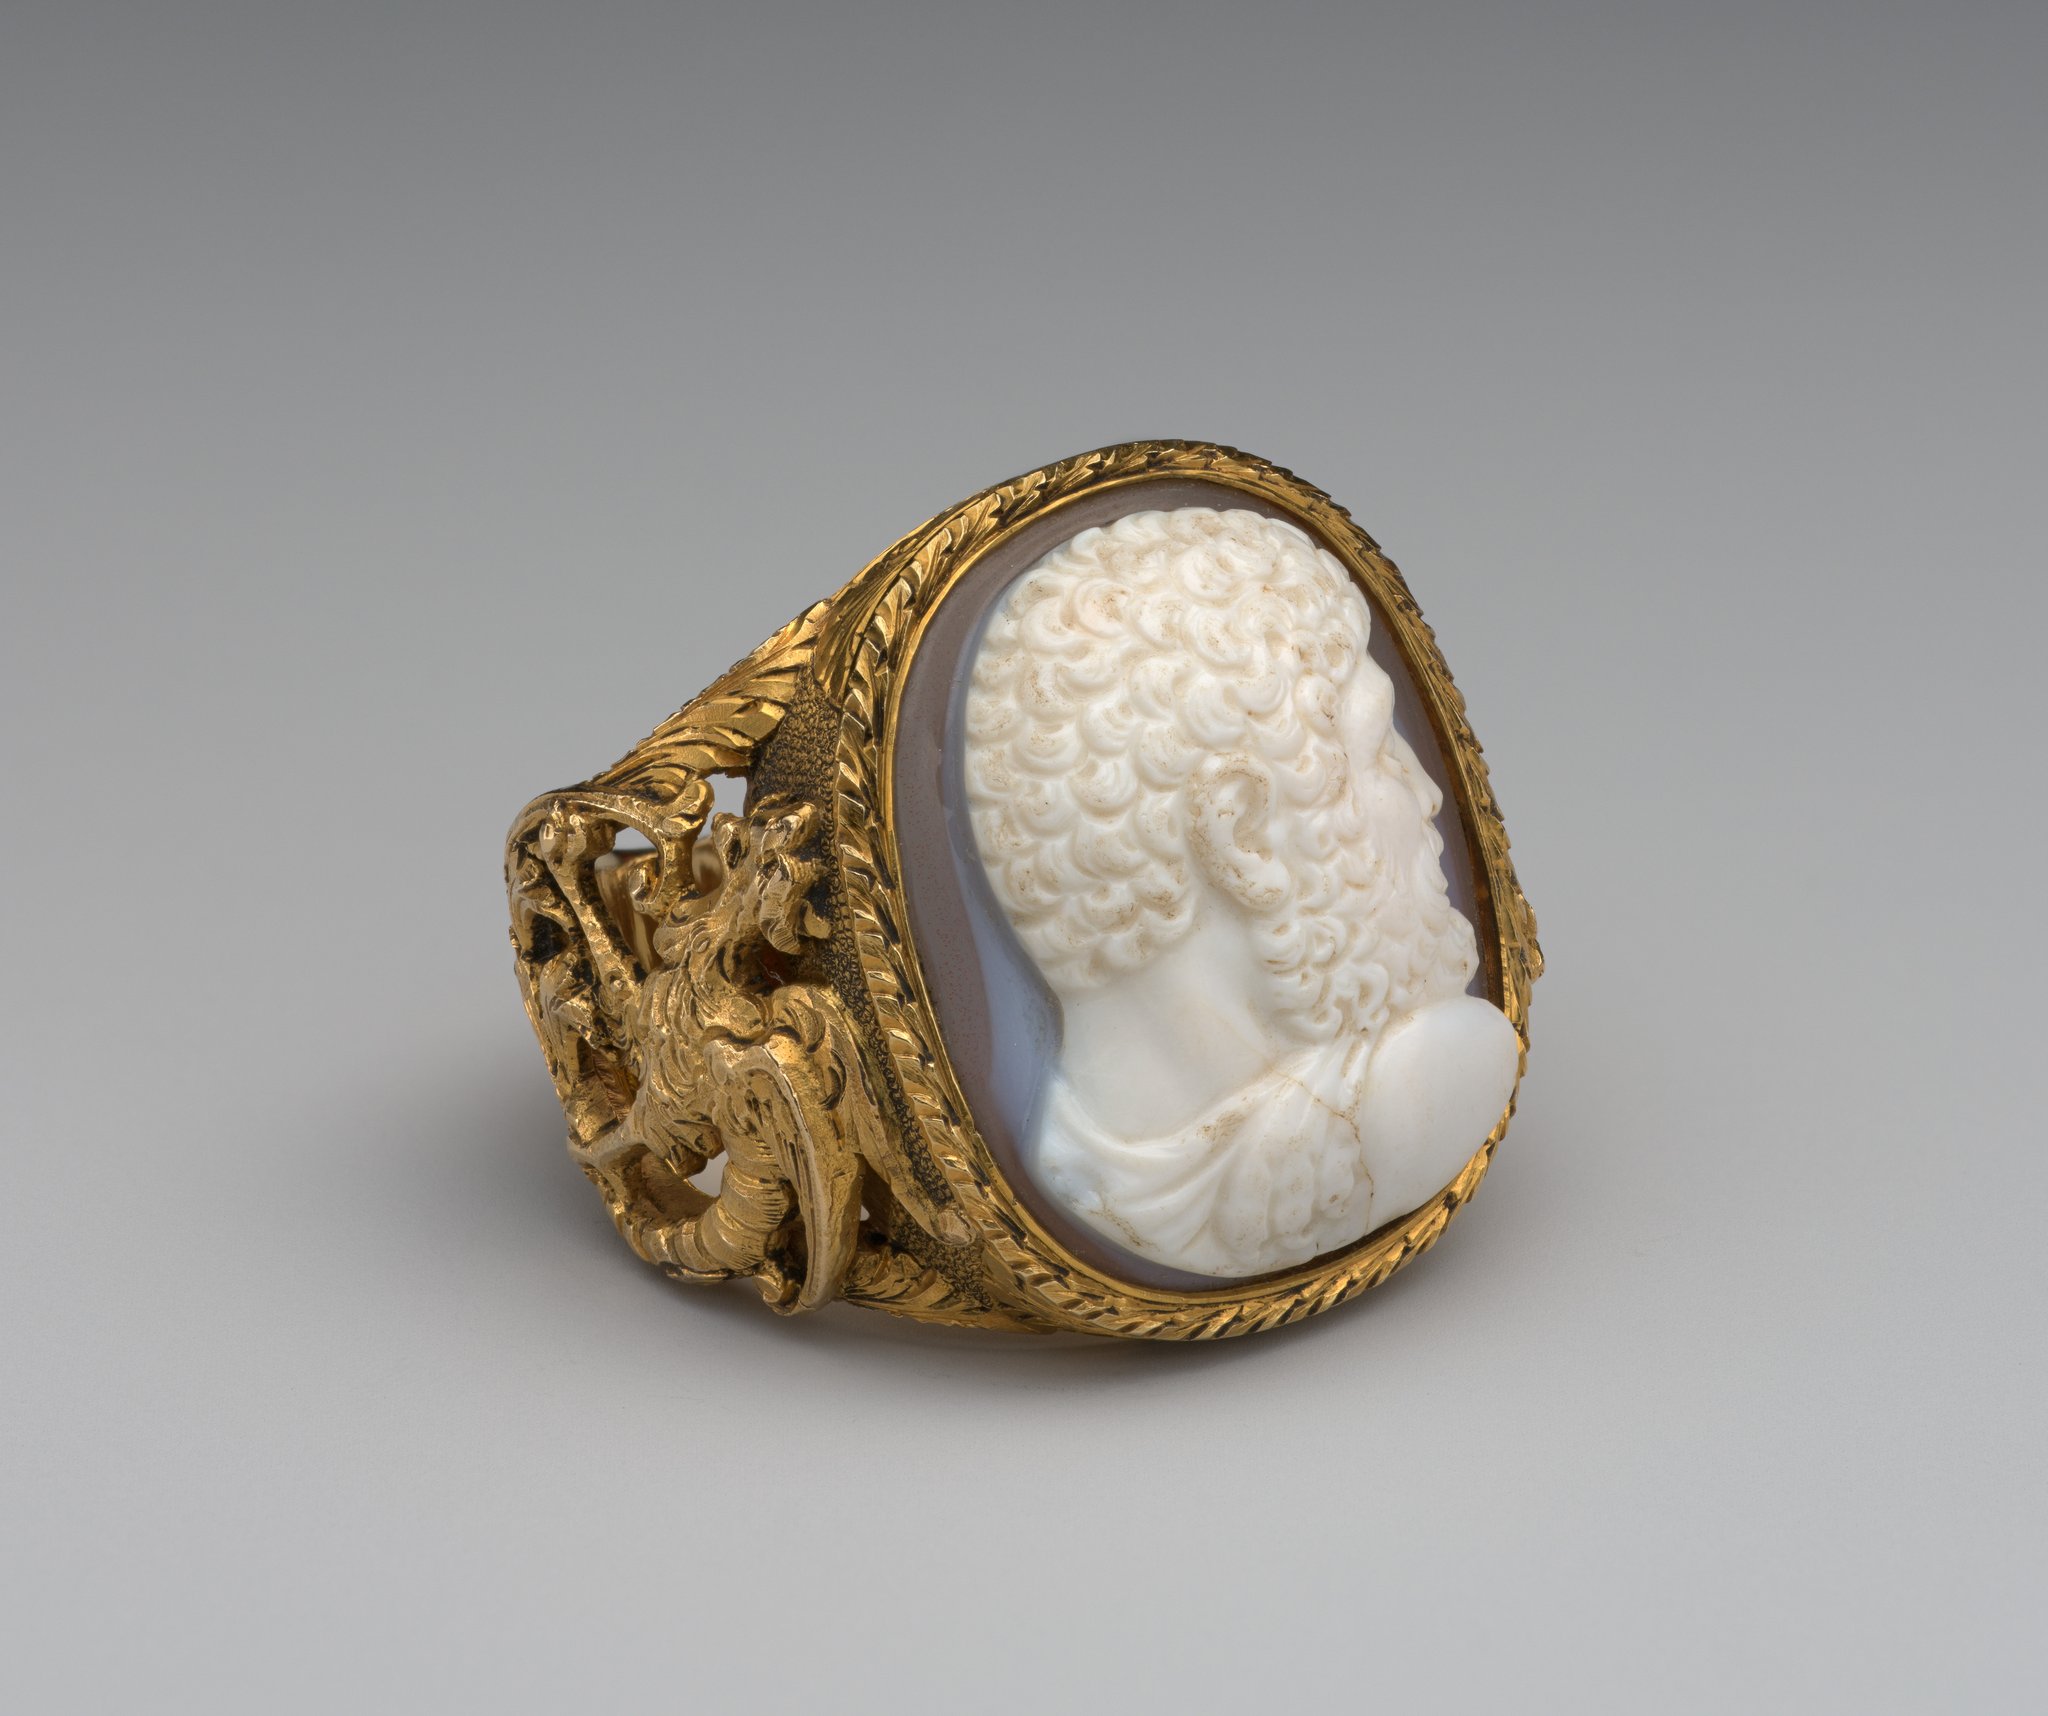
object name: ring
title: Cameo of Hercules set in ring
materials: stone, gold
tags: hercules